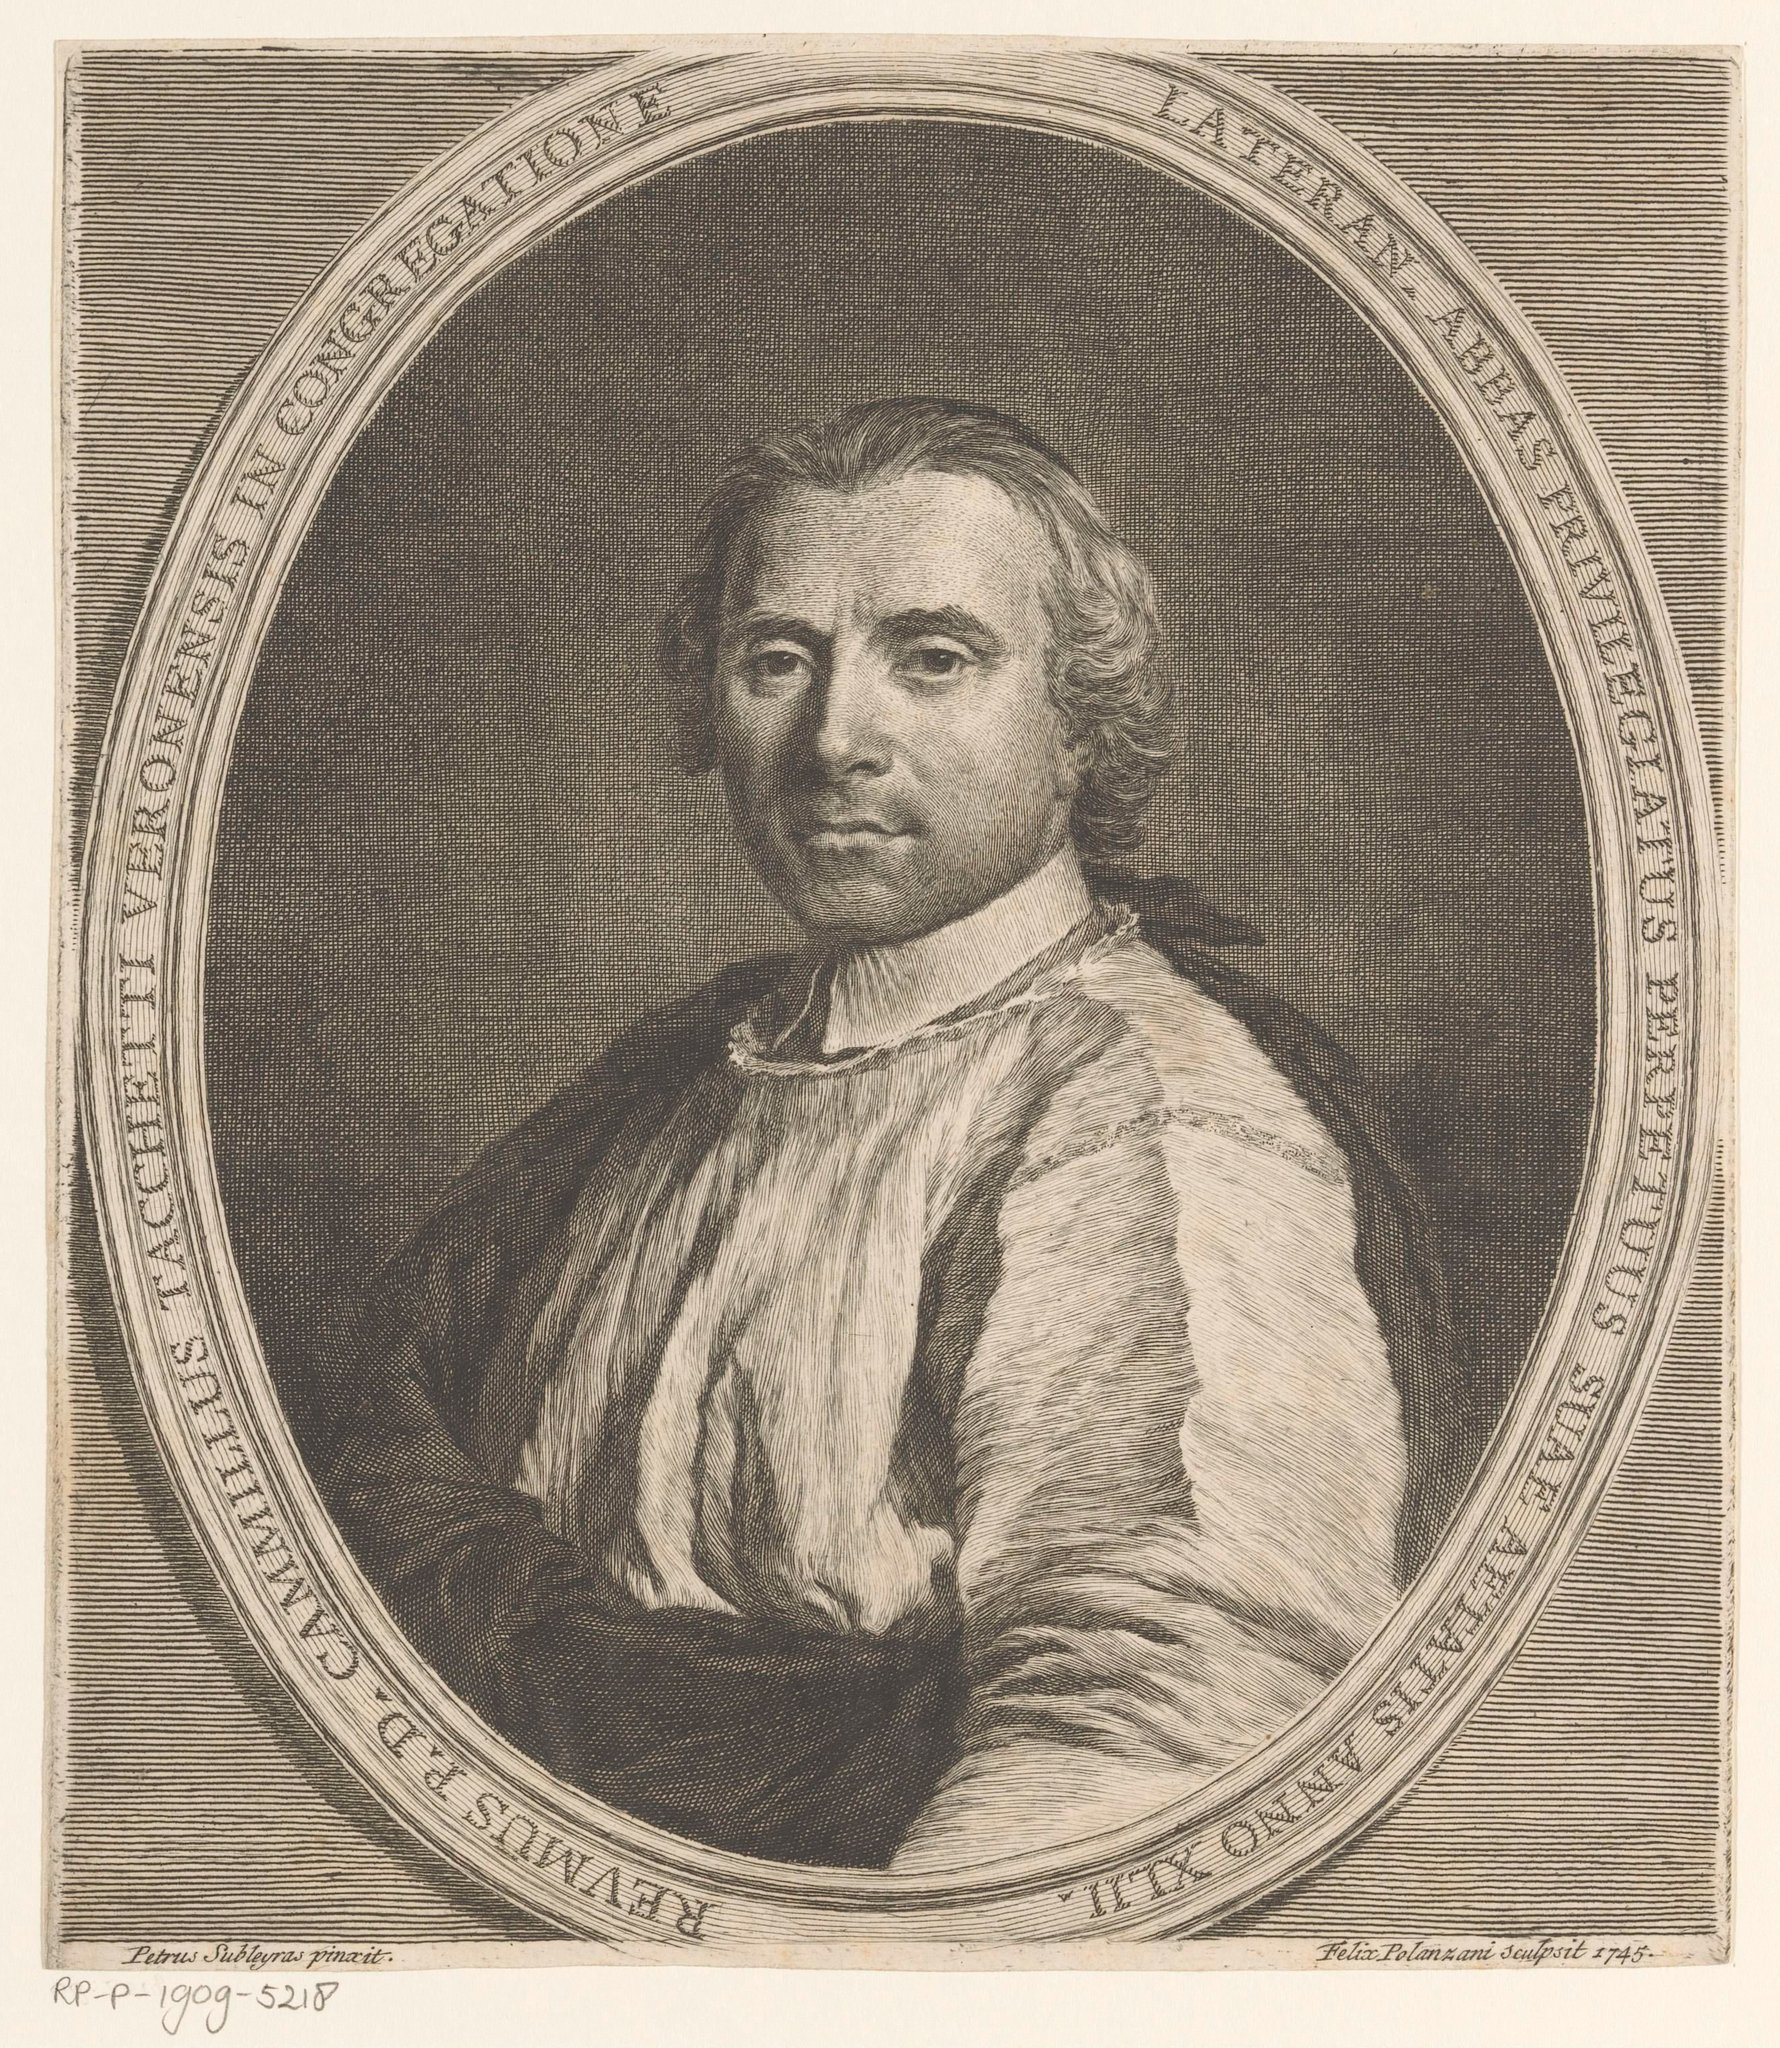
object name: print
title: Portret van Camillo Tacchetti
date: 1745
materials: paper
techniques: etching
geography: italy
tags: historical persons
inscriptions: collector's mark: Lugt 2228